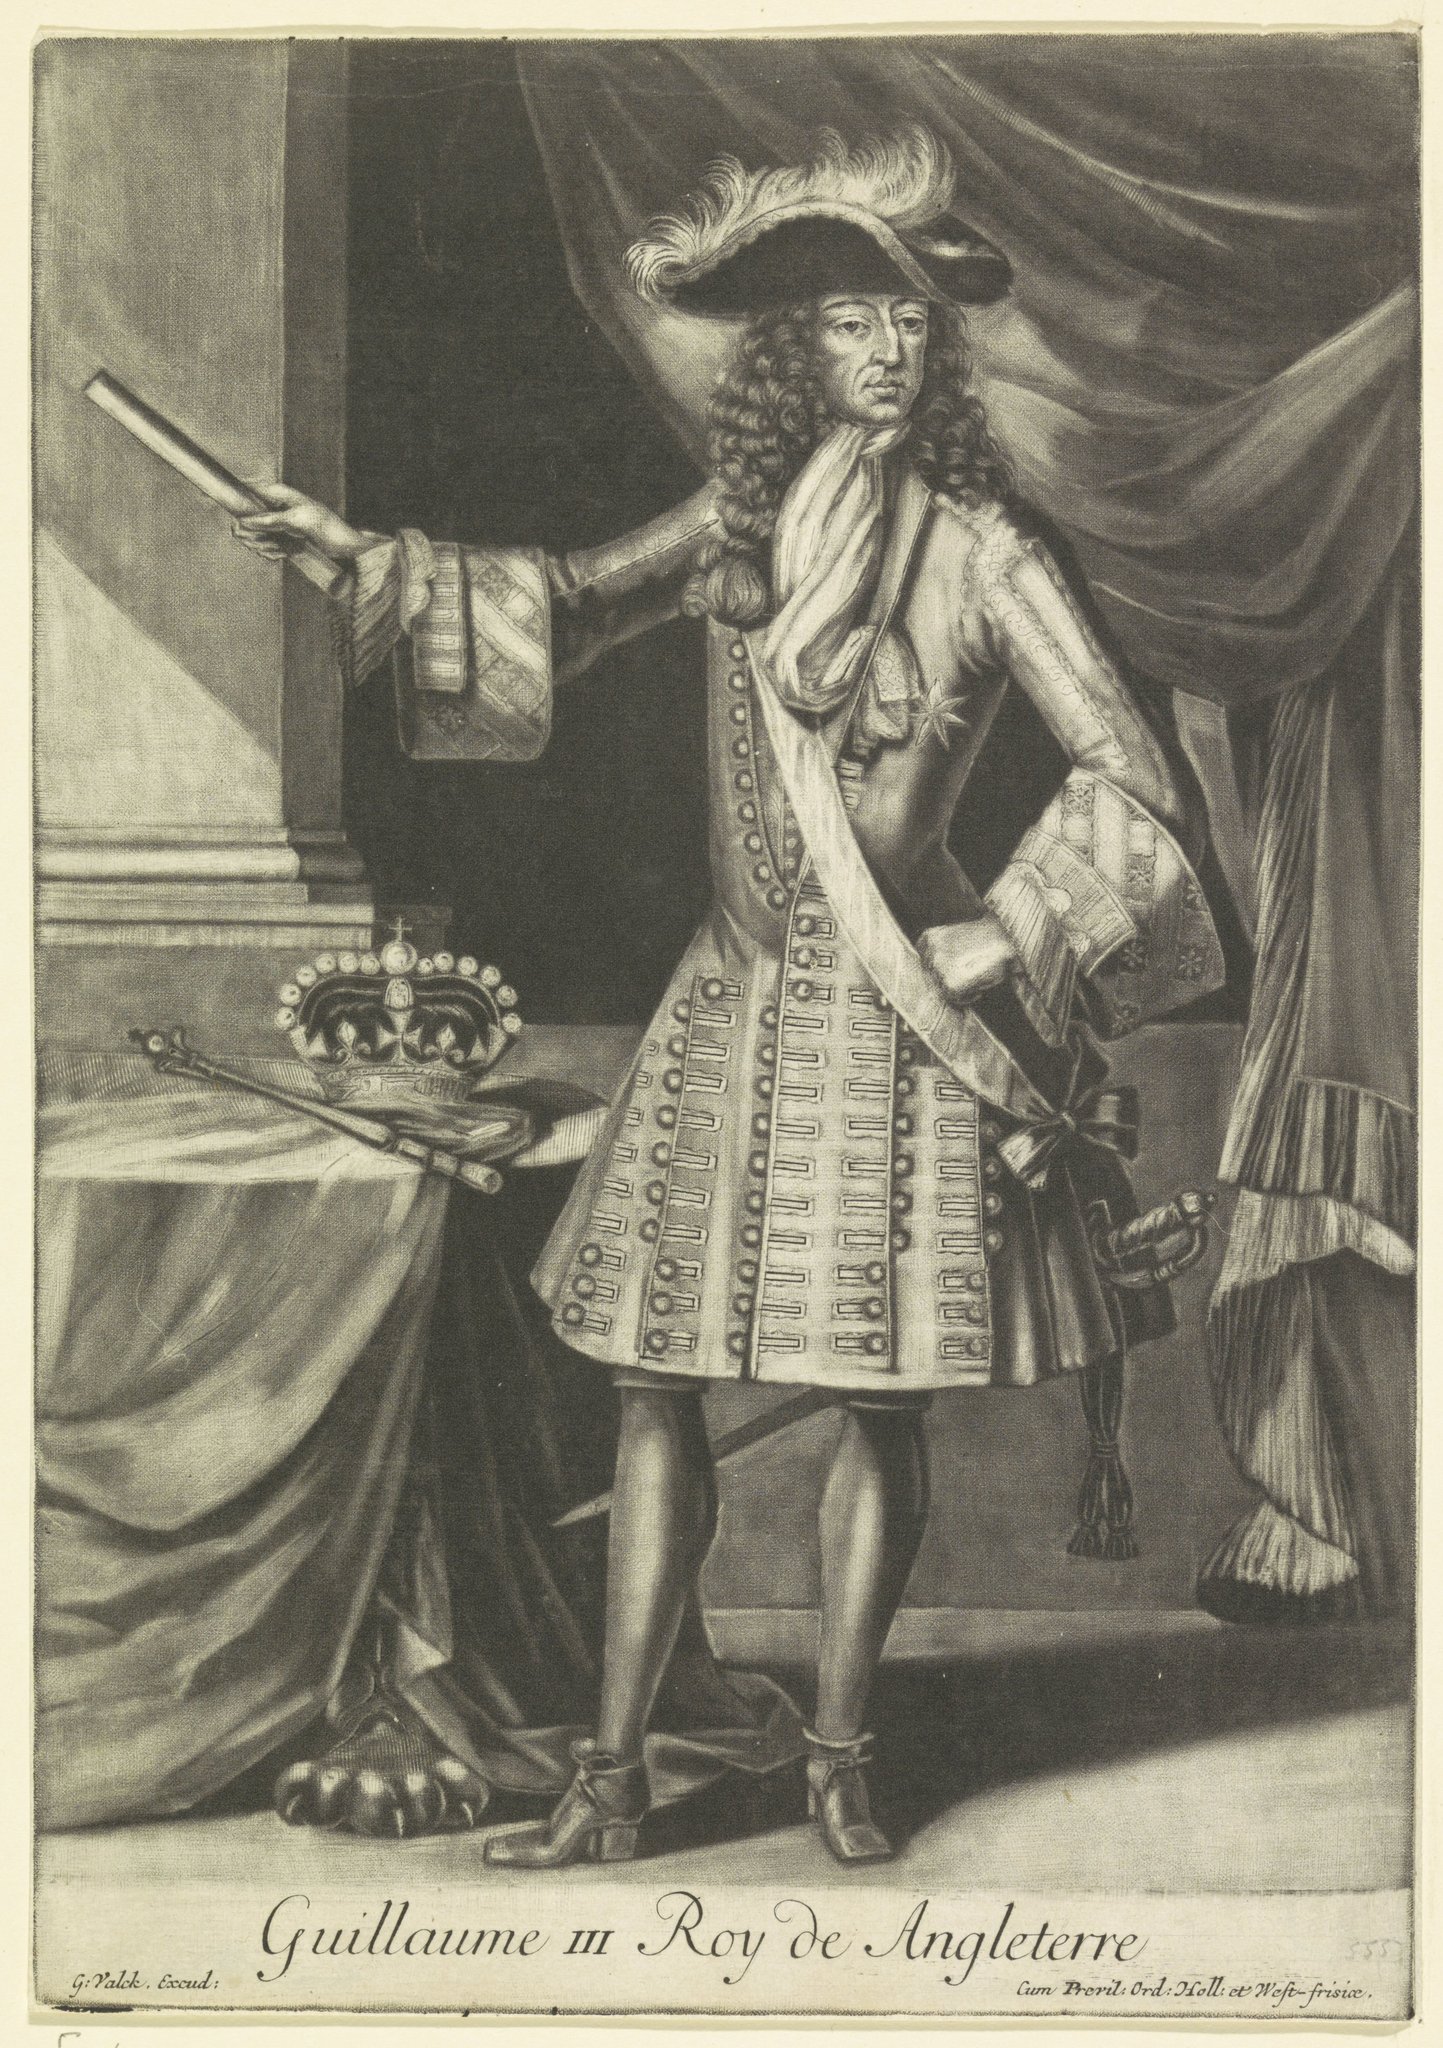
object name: print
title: Portret van Willem III, prins van Oranje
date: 1688-1726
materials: paper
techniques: mezzotint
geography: amsterdam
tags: william iii (prince of orange and king of england, scotland, and ireland)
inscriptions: collector's mark: Lugt 963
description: Portret van Willem III met een hoed. Hij staat in een vertrek naast een tafel met daarop zijn kroon en scepter. In zijn rechterhand een commandostaf. In de ondermarge zijn naam en titel in het Frans.